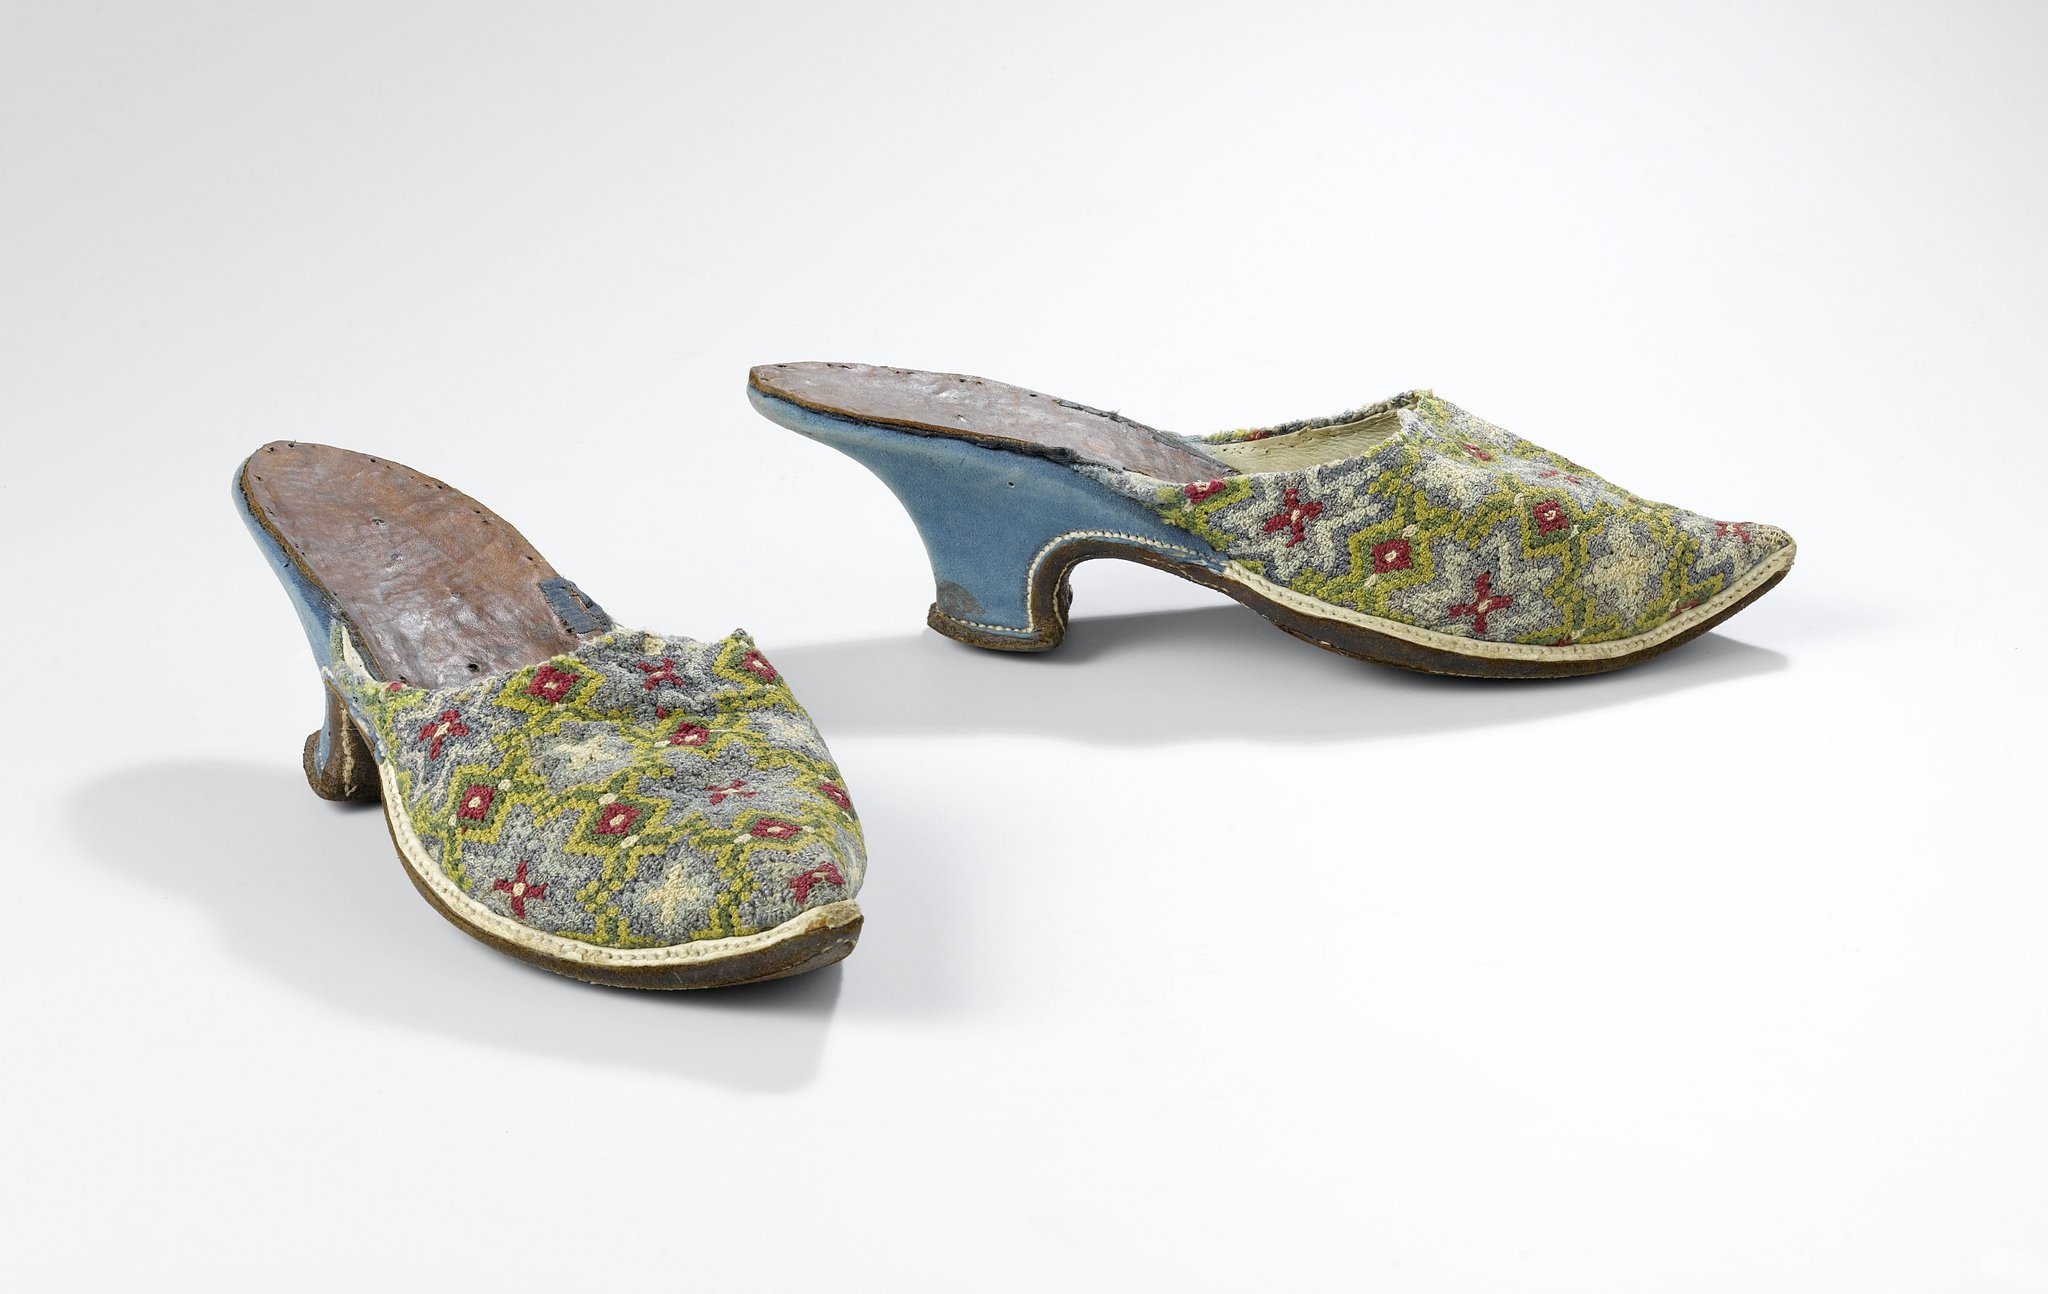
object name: mule shoe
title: Muiltje met geborduurd voorblad van zijde op stramien, met patroon van blauwe sterbloemen op geel fond met groen netwerk met rode ruiten en witte punten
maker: Anonymous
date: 1660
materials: leather, linen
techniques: embroidered, tanning, weave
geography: netherlands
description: Paar muiltjes of trippen, linnen of hennep stramien, floszijde, wol, kalfsleer, rundleer, zeemleer Nederland, ca. 1660 Inv. BK-1978-293-a/b Oorspronkelijk was de binnenzool geheel bedekt met fluweel.